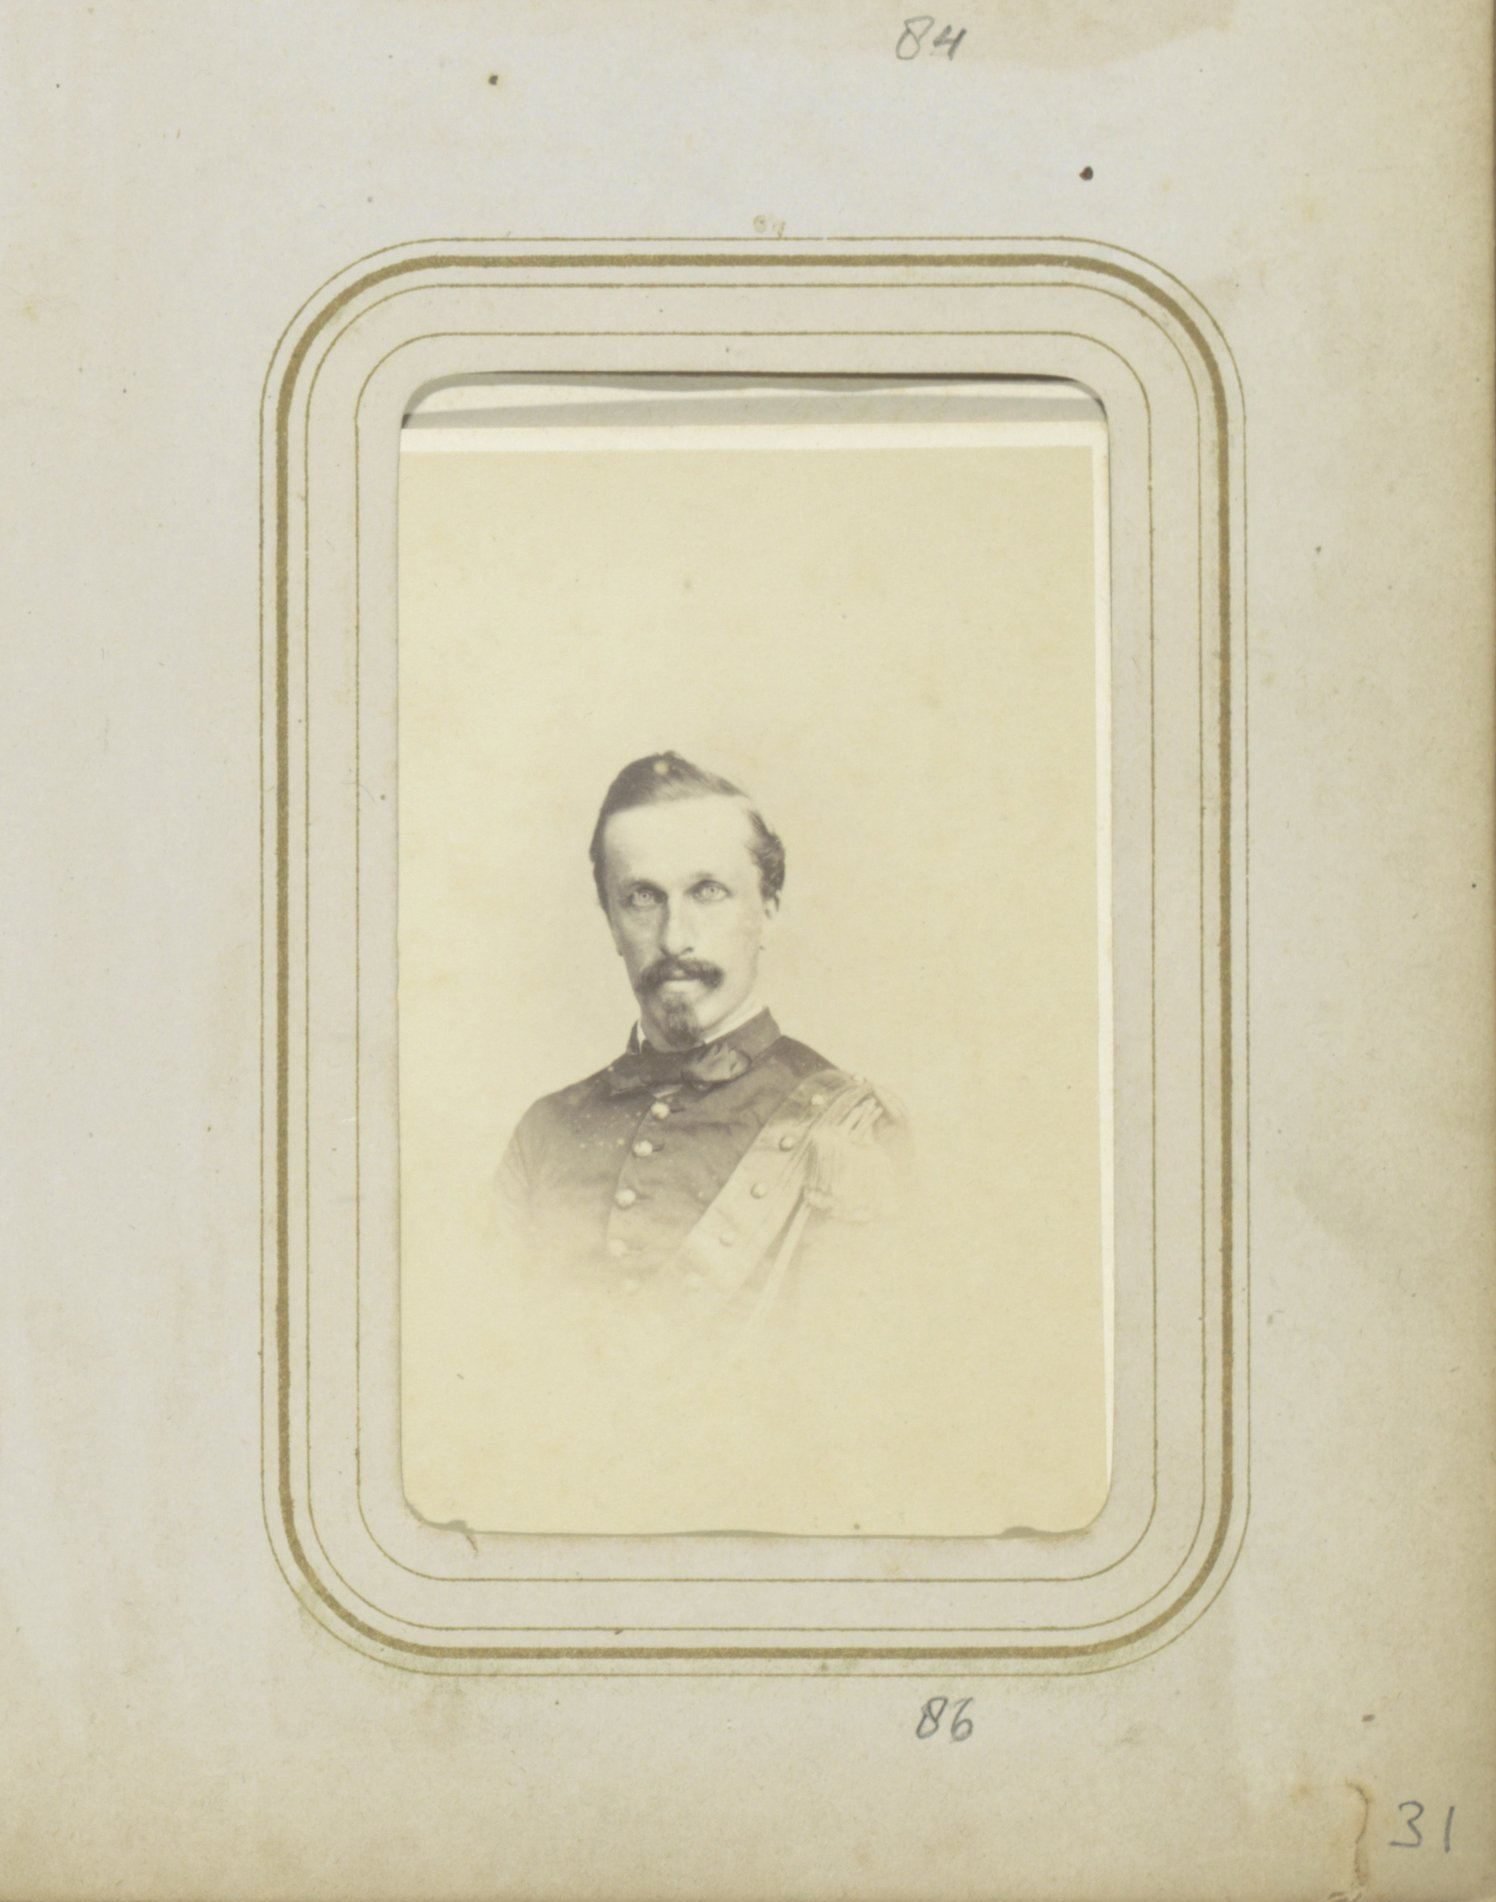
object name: carte de visite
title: Portret van een man met snor en baard in militair kostuum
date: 1857-1880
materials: cardboard, photographic support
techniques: albumen print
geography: java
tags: historical persons, neck-gear ~ clothing, family, relationship, descent, medals and other marks of military honour, hairdress, (military) uniforms, beard, java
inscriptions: address: ‘Java’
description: Onderdeel van Familiealbum van H.W.F. Ligtenberg en L.M. Swart met 149 foto's en cartes-de-visite.